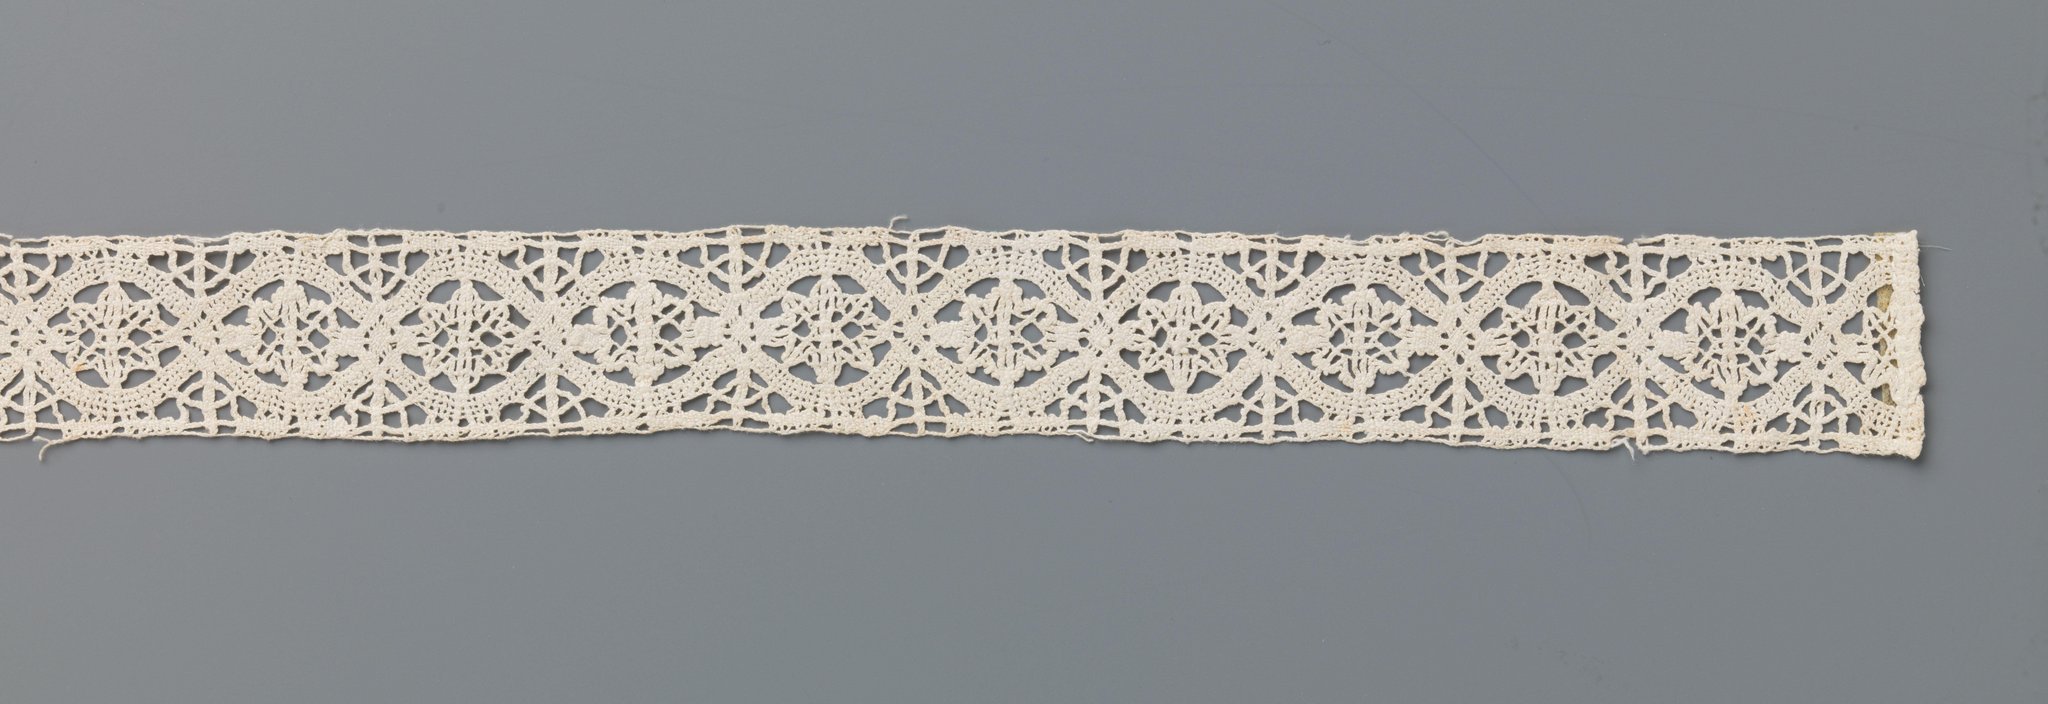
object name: entre deux, tussenzetsel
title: Tussenzetsel van kloskant met achtpuntige bloem in een ovaal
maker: Anonymous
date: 1600-1649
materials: linen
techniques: lace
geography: italy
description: Tussenzetsel voor een laken van naturelkleurige kloskant. Het patroon bestaat uit een zich herhalend en symmetrisch motief van een achtpuntige bloem binnen een ovaal, die tussen twee vertikale lijnen is geplaatst. De vertikale lijnen lopen van boven naar beneden over de breedte van de strook. Boven- en onderzijde van de strook zijn recht afgewerkt.